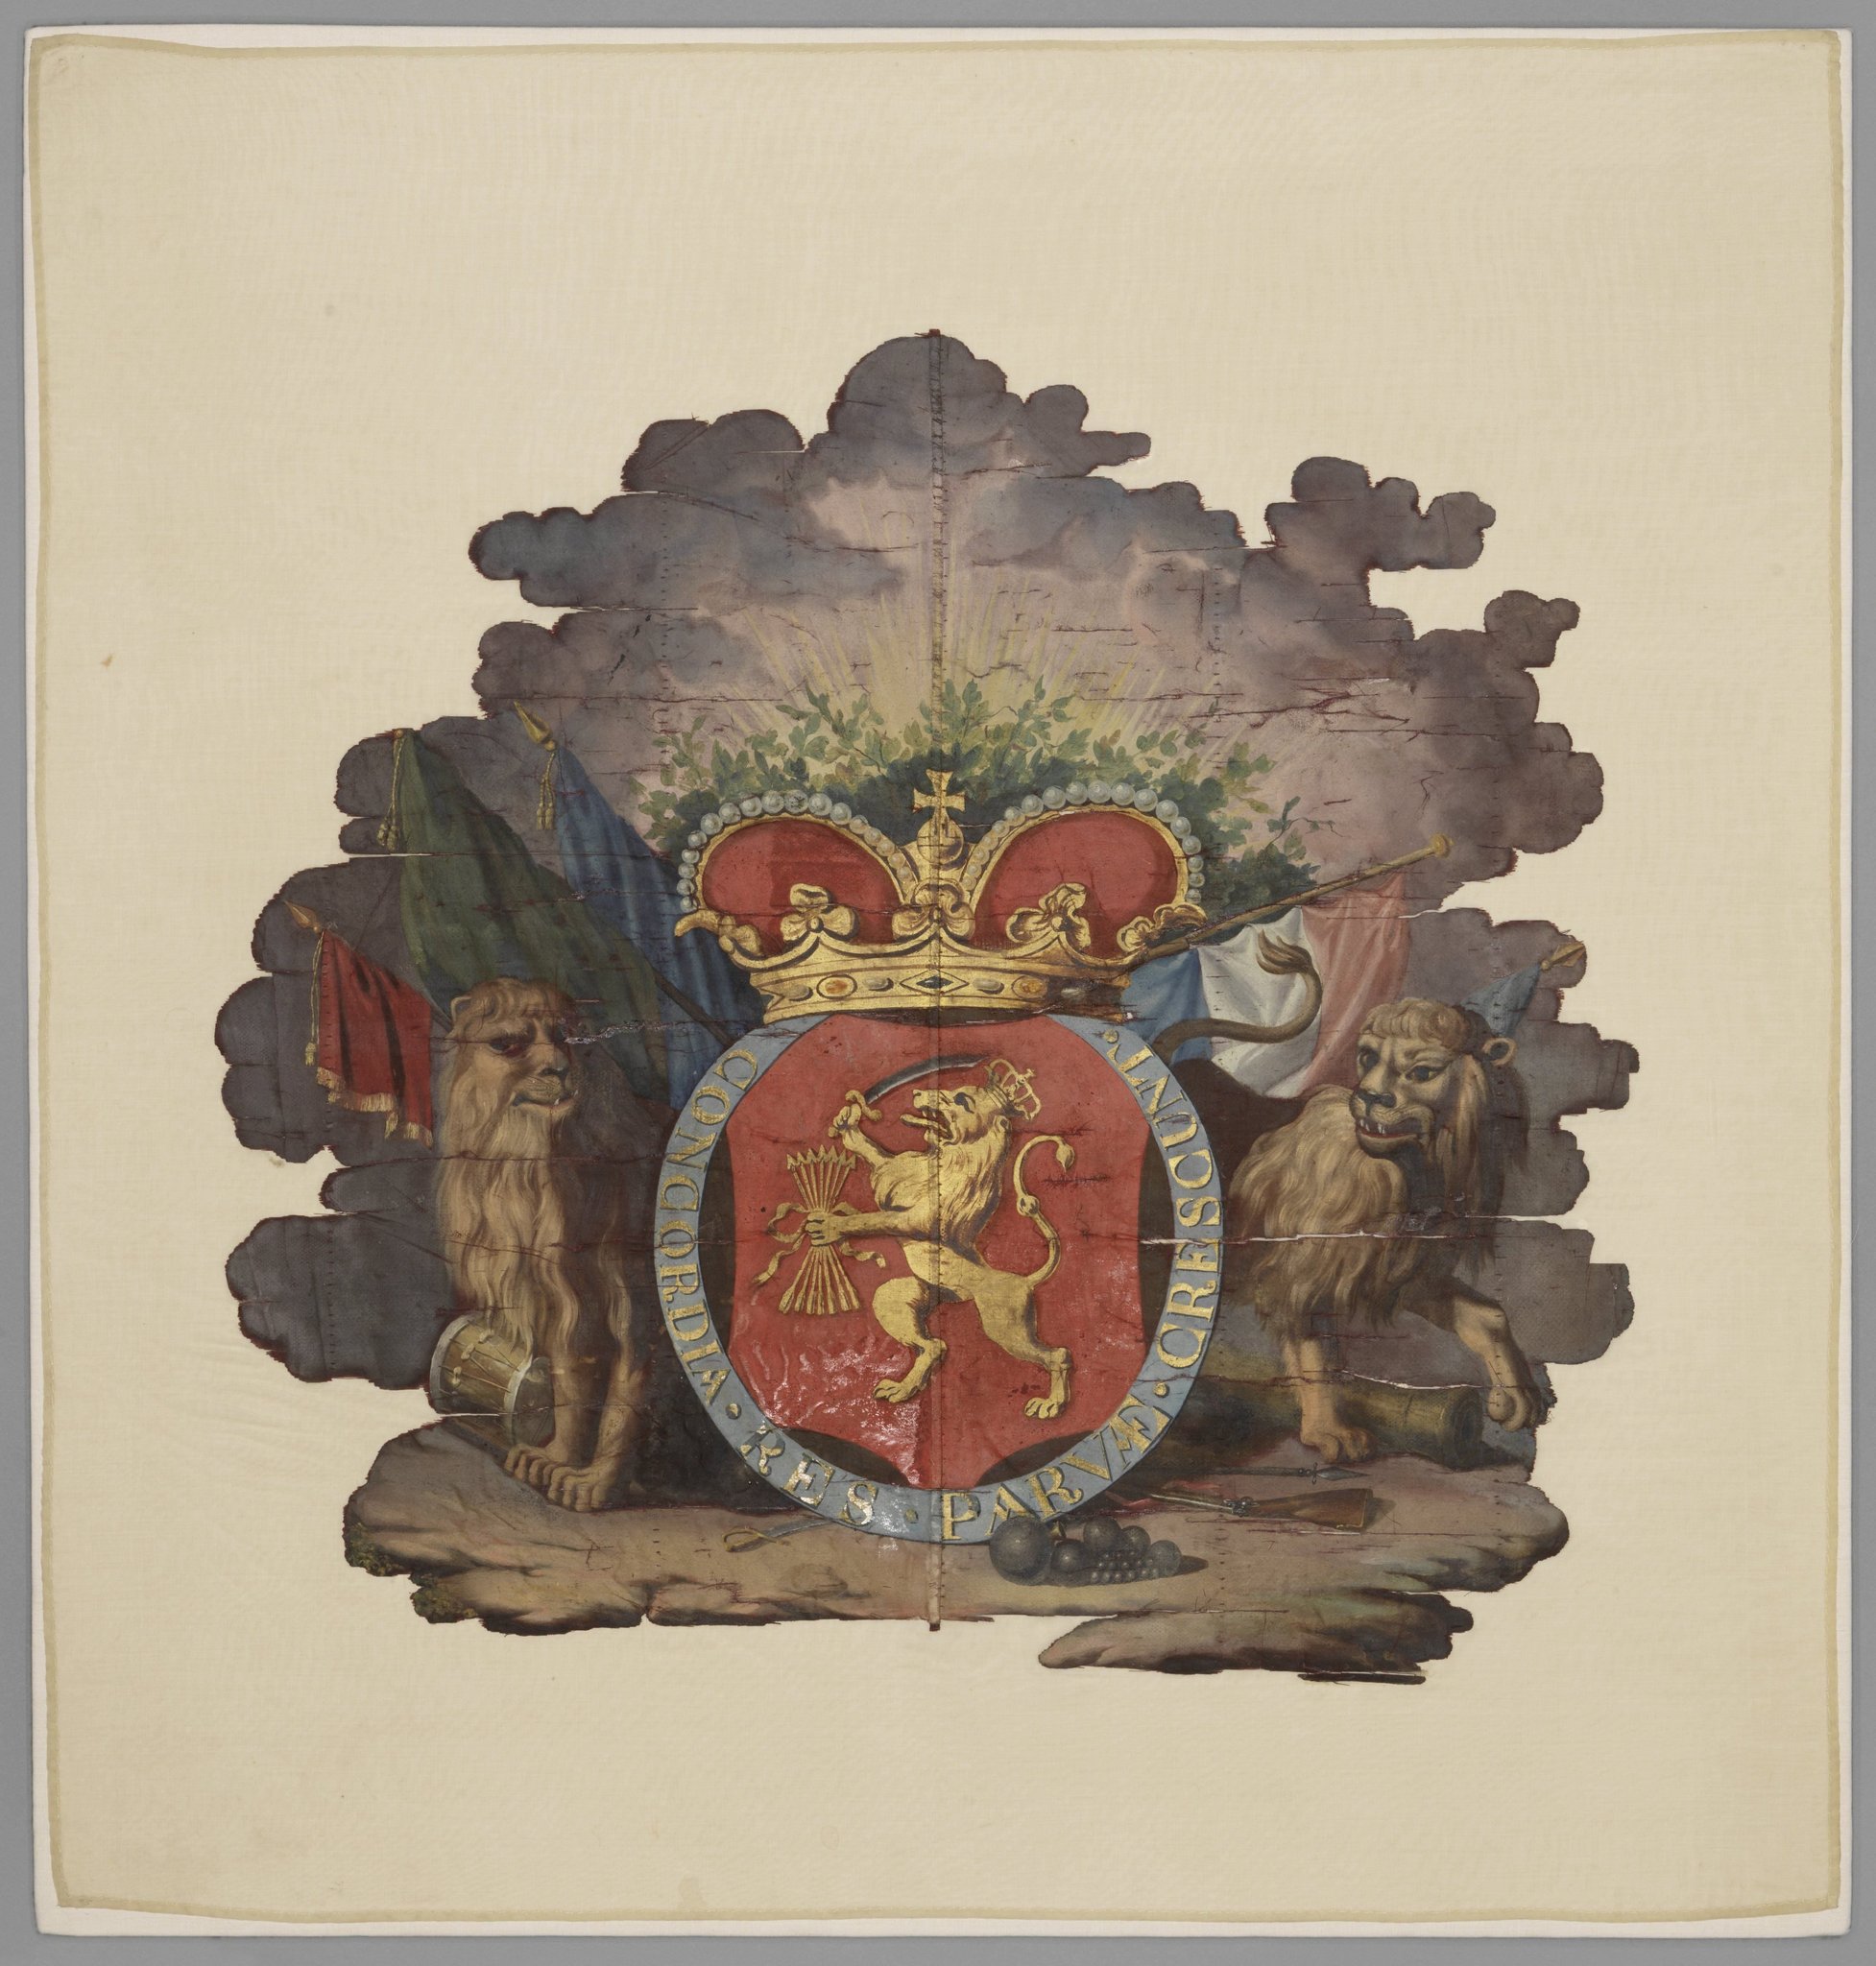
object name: banner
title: Vaandel van een der regimenten Baden-Durlach (vermoedelijk)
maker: Anonymous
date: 1747-1789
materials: paint, silk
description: Rood, op het midden het wapen van Baden, gedekt door vorstenkroon, omgeven door een wit, rood en zwart versierde band (een verhaspelde Gulden Vliesketen ?). Het geheel wordt gehouden door twee griffioenen (aan vluchtzijde afgewend), en is geplaatst op een trofee van vaandels, kanonnen enz.; achter de kroon een groene bosschage, waarachter zonnestralen en een wolkenpartij. Op de voorgrond ligt schuin aan de vluchtzijde een kruisvormig ordeteken. Paradekant: in plaats van het wapen van Baden het wapen van de Republiek. De ovale band eromheen is blauw waarop in gouden klassieke kapitalen: CONCORDIA RES PARVAE CRESCUNT, gedekt door een kroon met drie geparelde beugels en rode muts. Aan weerskanten een gaande leeuw. Het geheel is geplaatst op een trofee van vaandels, trommels, kanonnen, kogels, geweren enz. Op de achtergrond een bosschage met zonnestralen en wolken als voorkant.